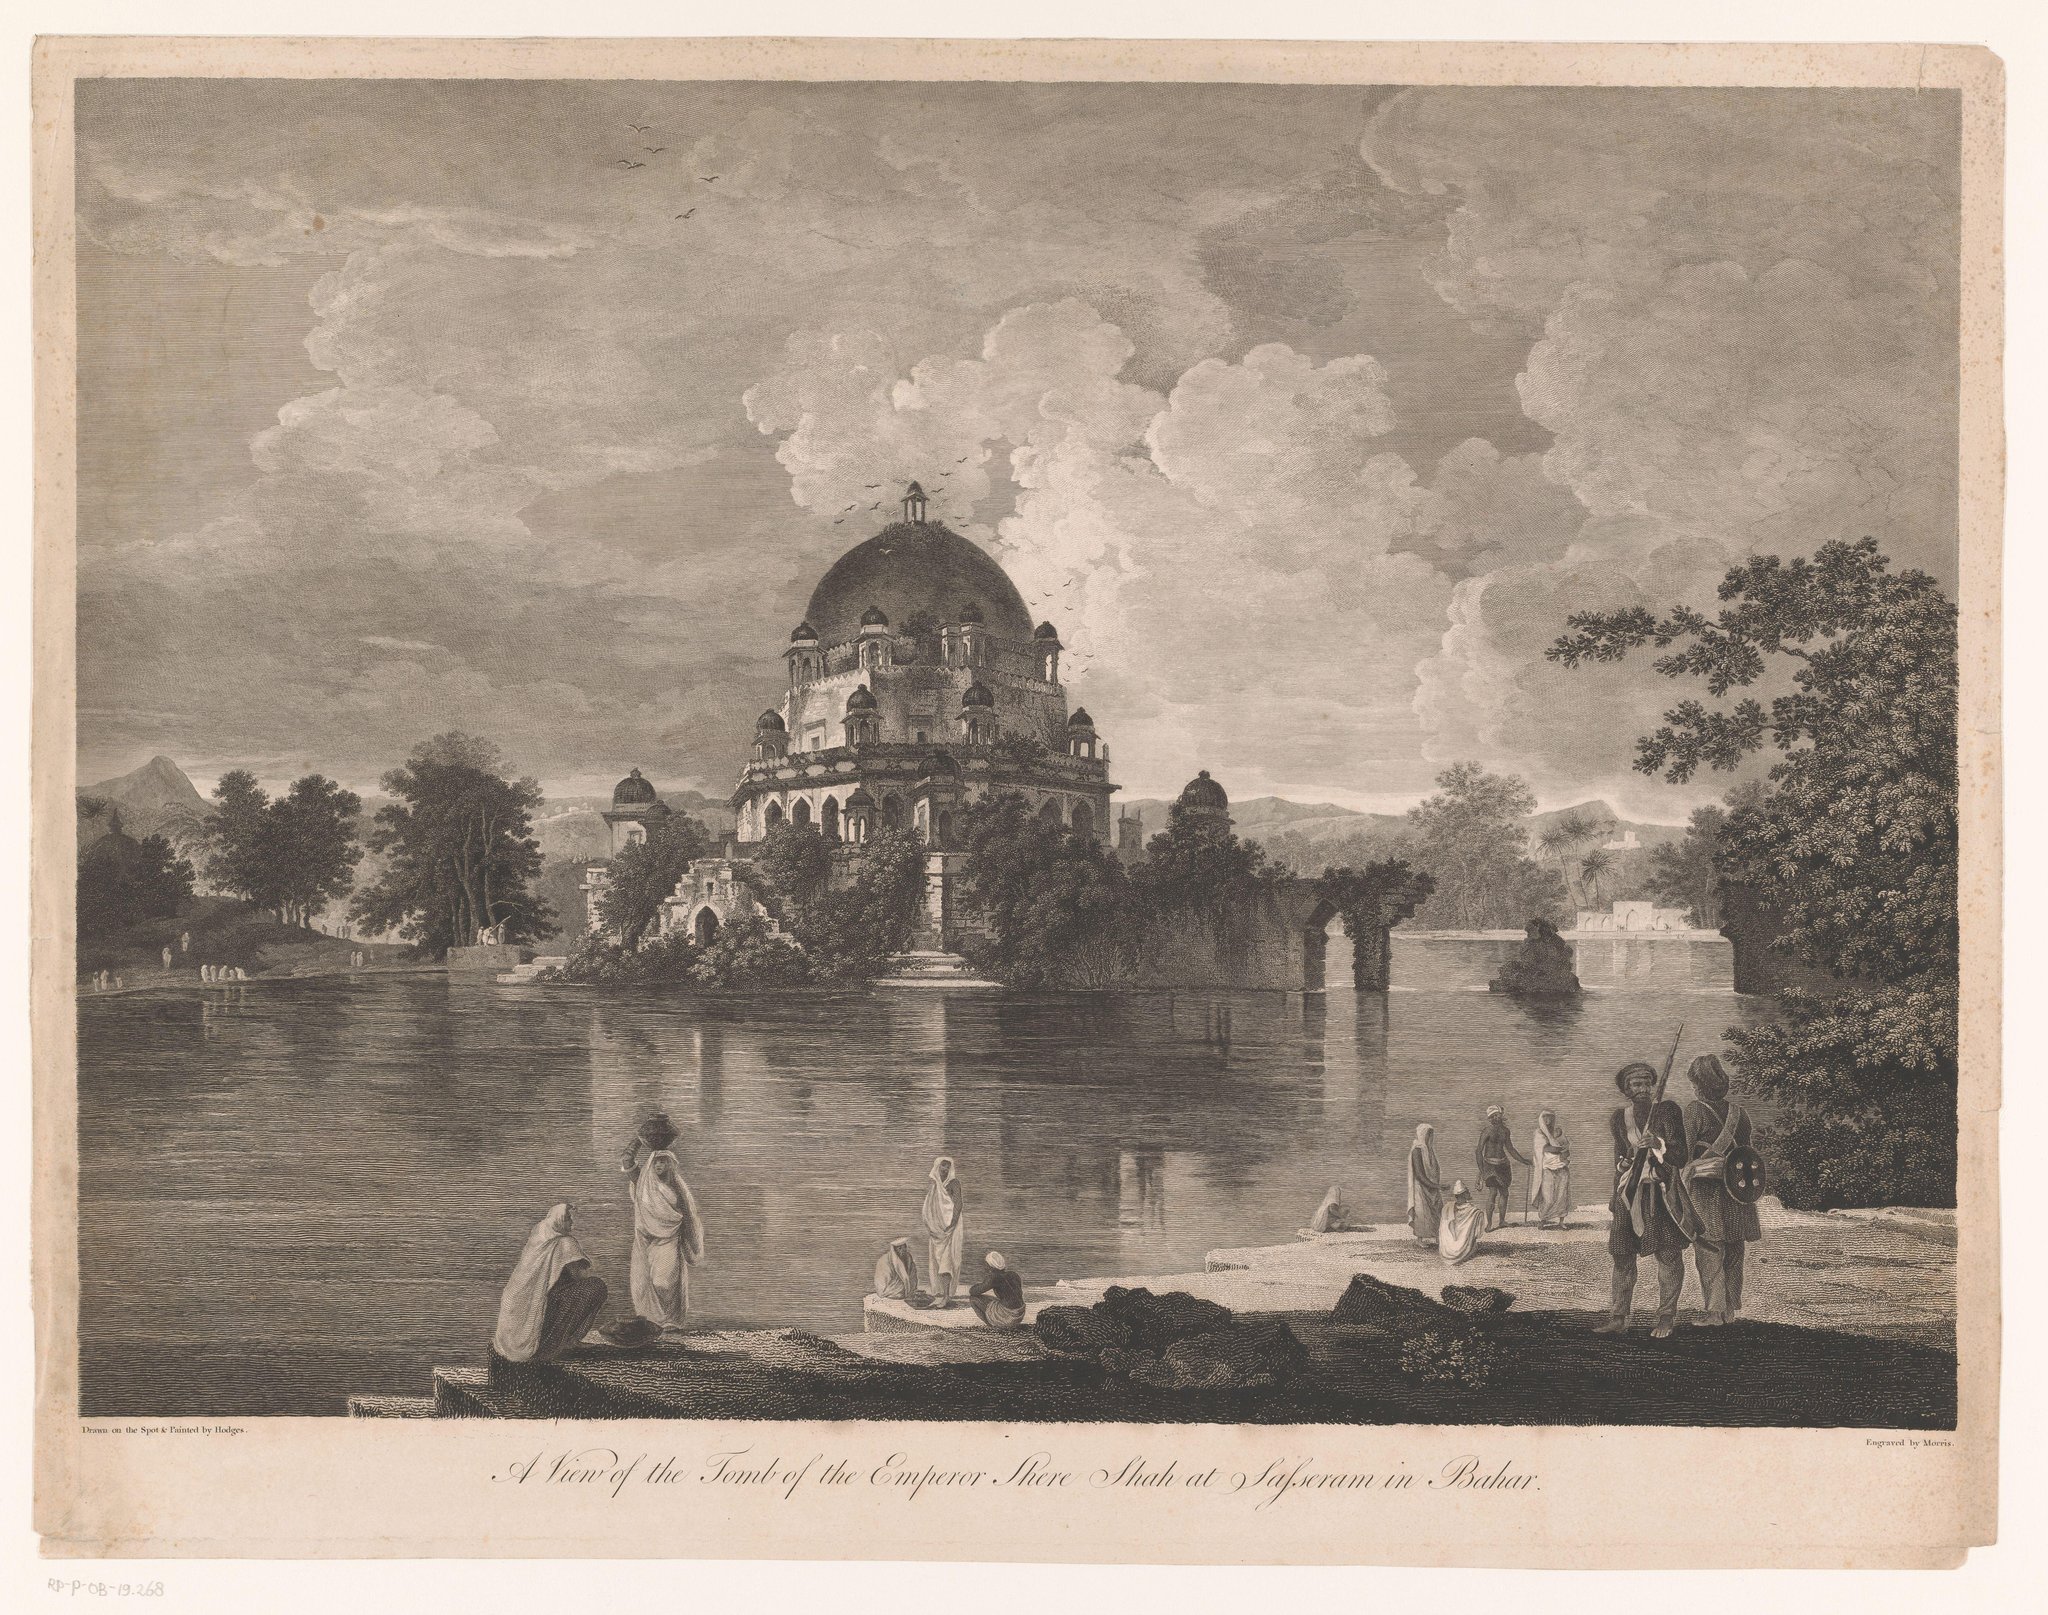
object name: print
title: A View of the Tomb of the Emperor Shere Shah at Sasseram in Bahar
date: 1760-1786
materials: paper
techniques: engraving, etching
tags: mausoleum, pond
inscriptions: collector's mark: Lugt 2228